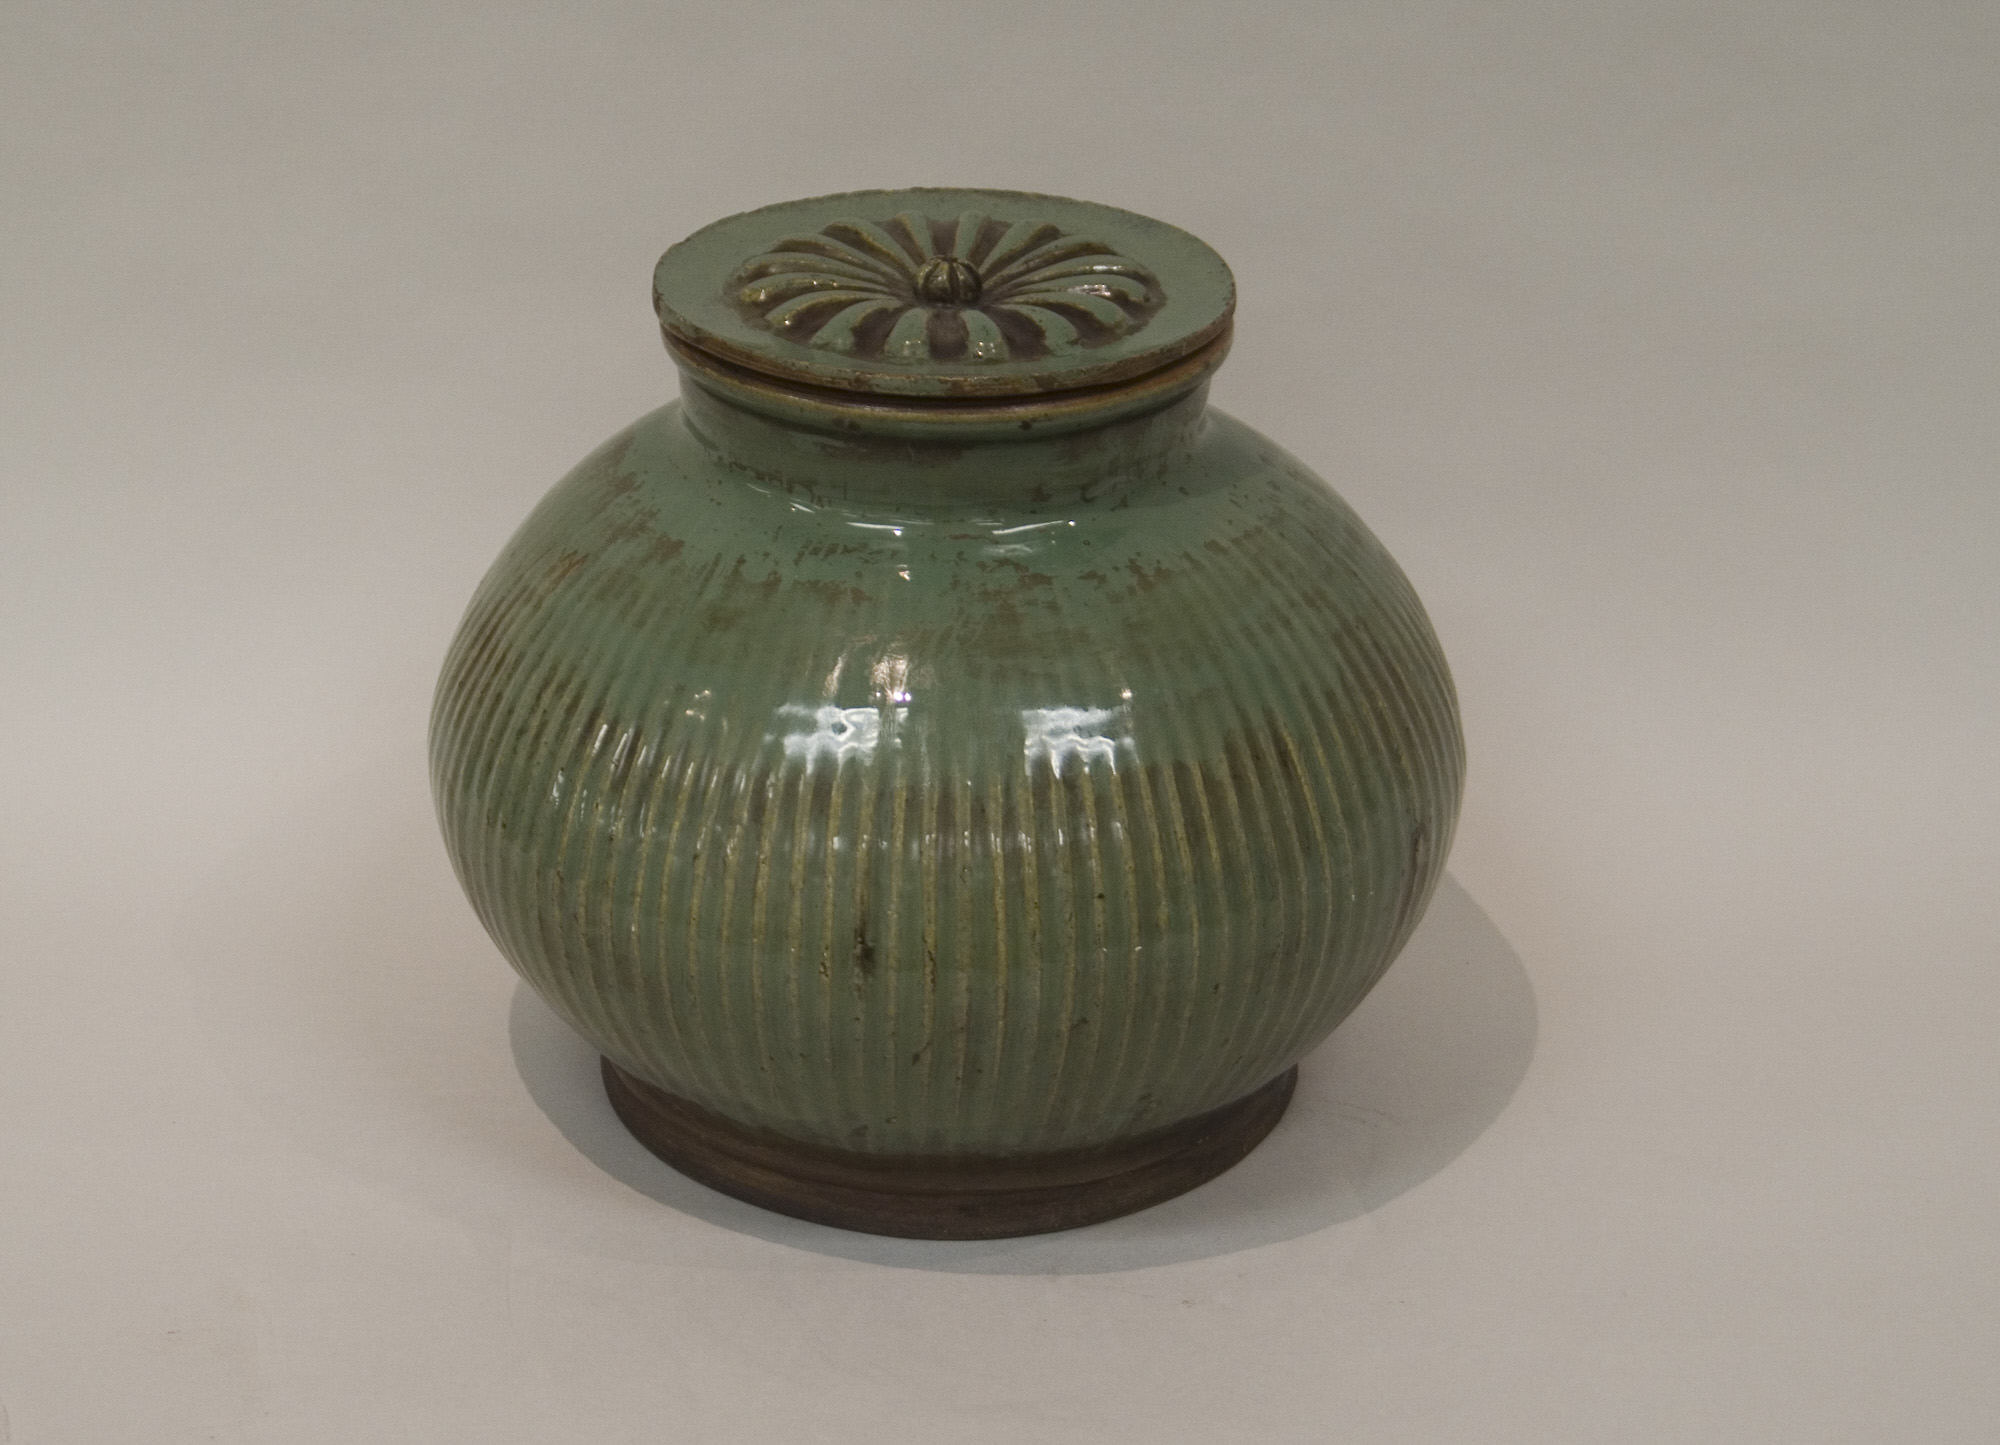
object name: jar with cover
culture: chinese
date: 1368-1644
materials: pottery